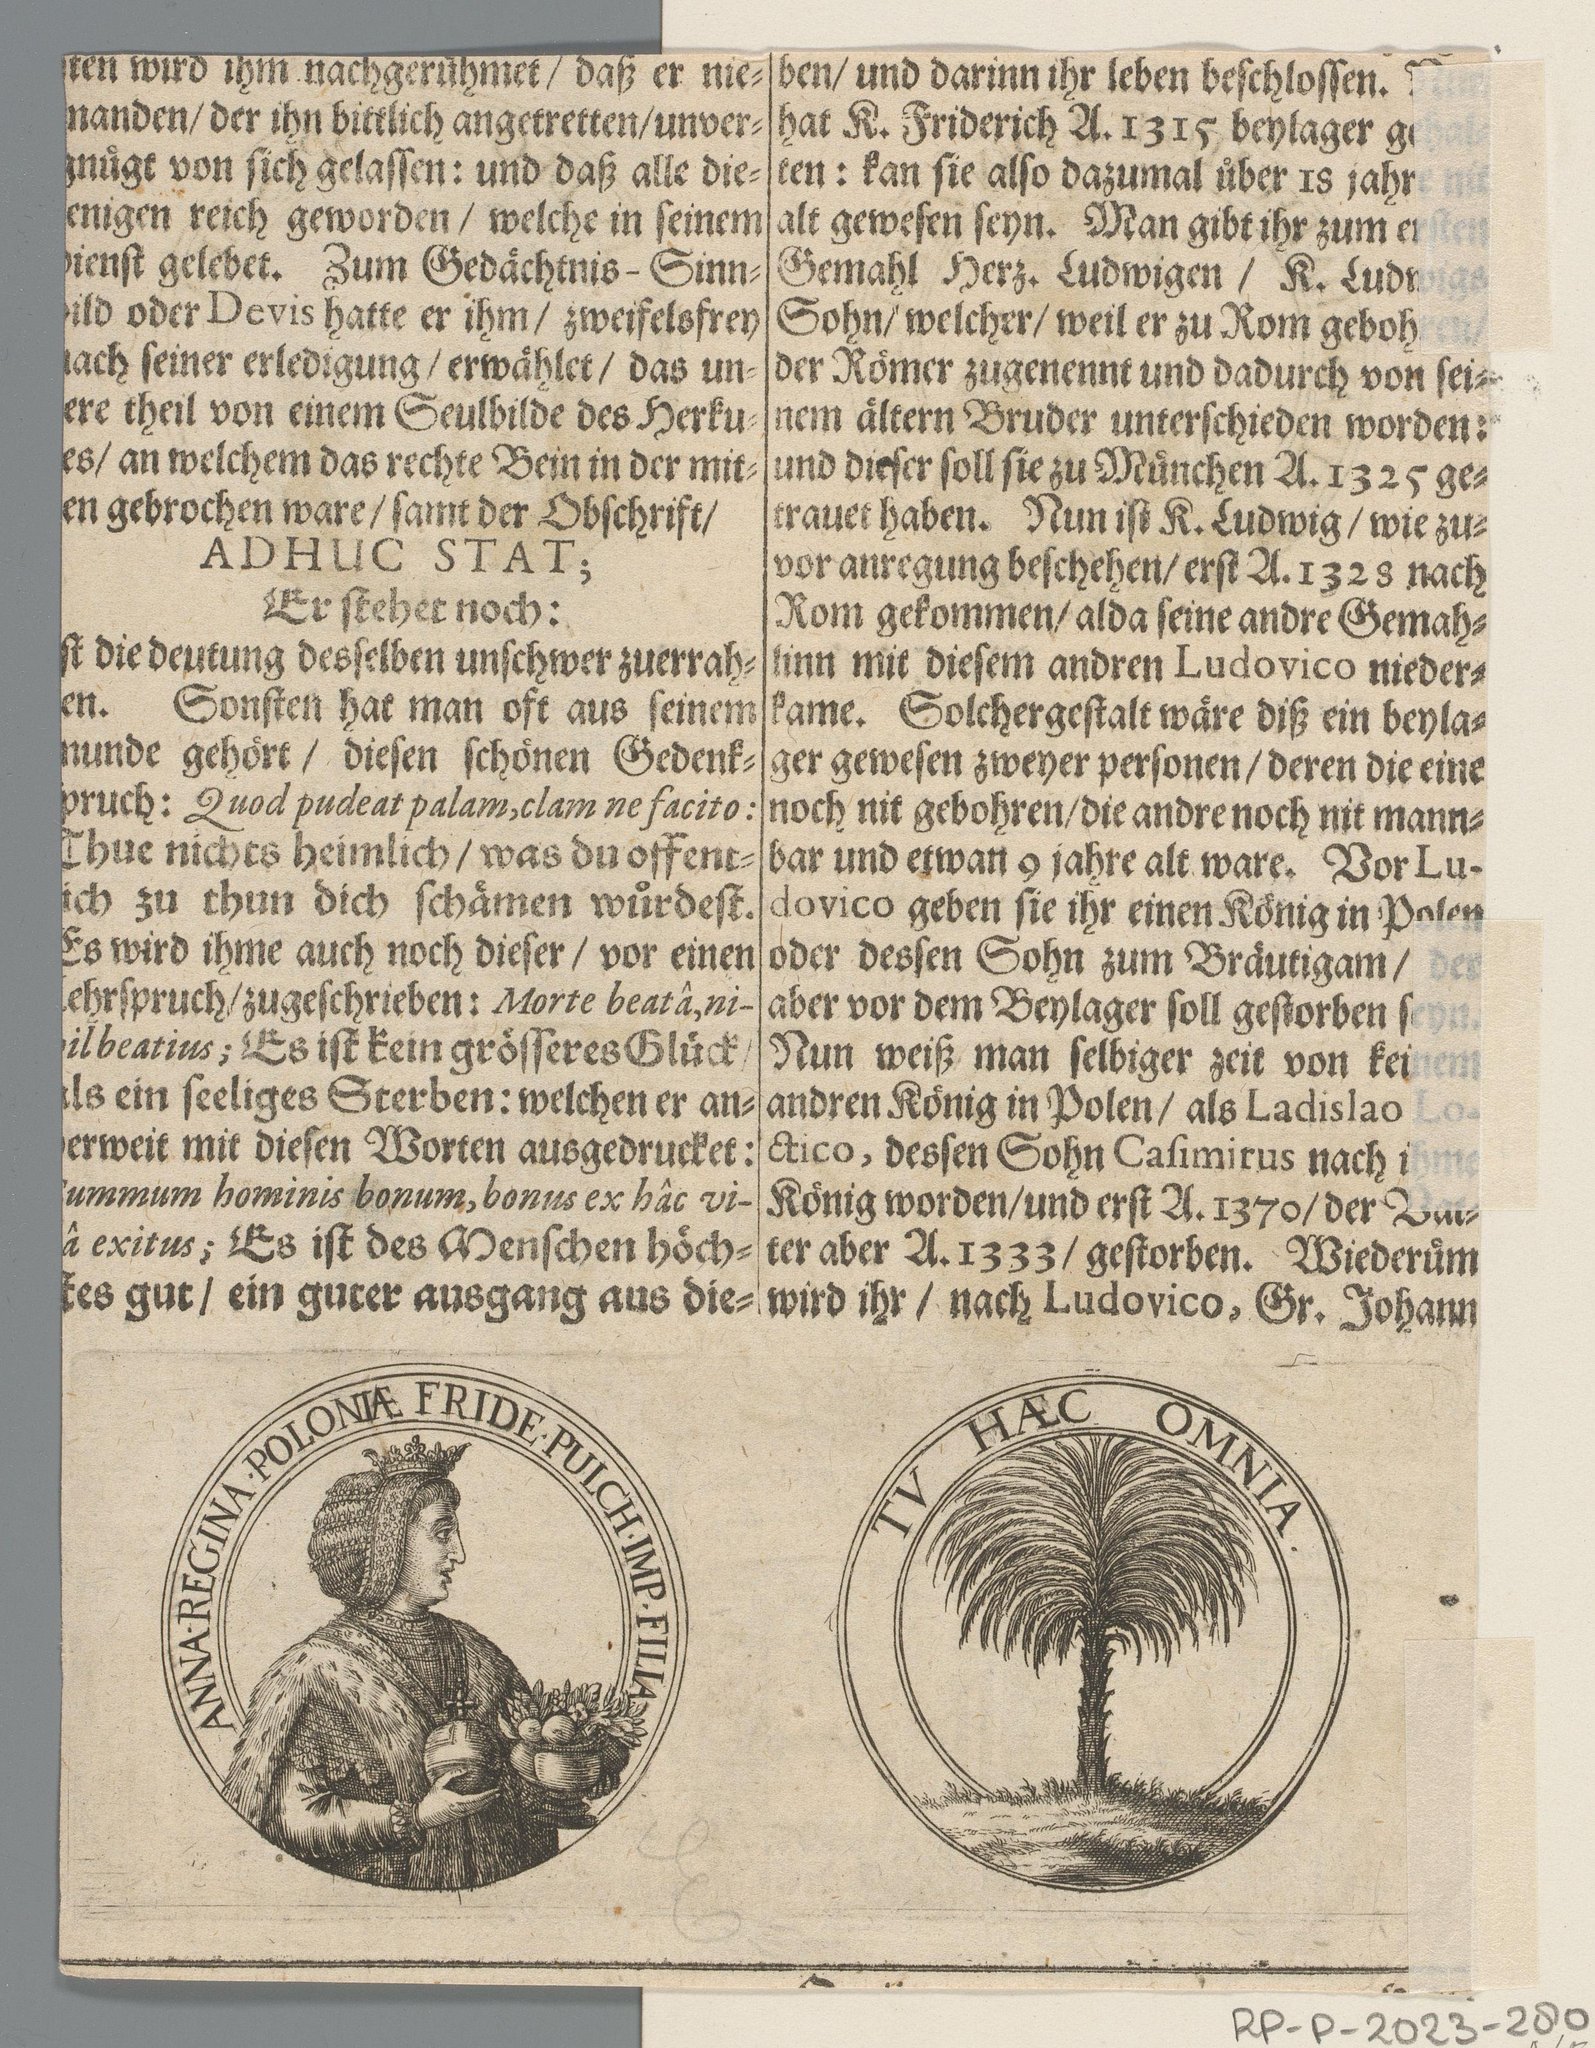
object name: print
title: Voor- en achterzijde van een penning met het portret van Anna Jagellonia van Polen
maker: Anonymous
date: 1668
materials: paper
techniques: etching, letterpress printing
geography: nuremberg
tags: historical persons - bb - woman, queen, empress, etc. (wife of a ruler)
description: Prent uit: Fugger, Johann Jakob. Spiegel der Ehren des Höchstlöblichsten Kayser- und Königlichen Erzhauses Oesterreich (…). Neurenberg: Michael en Johann Friedrich Endter, 1668.